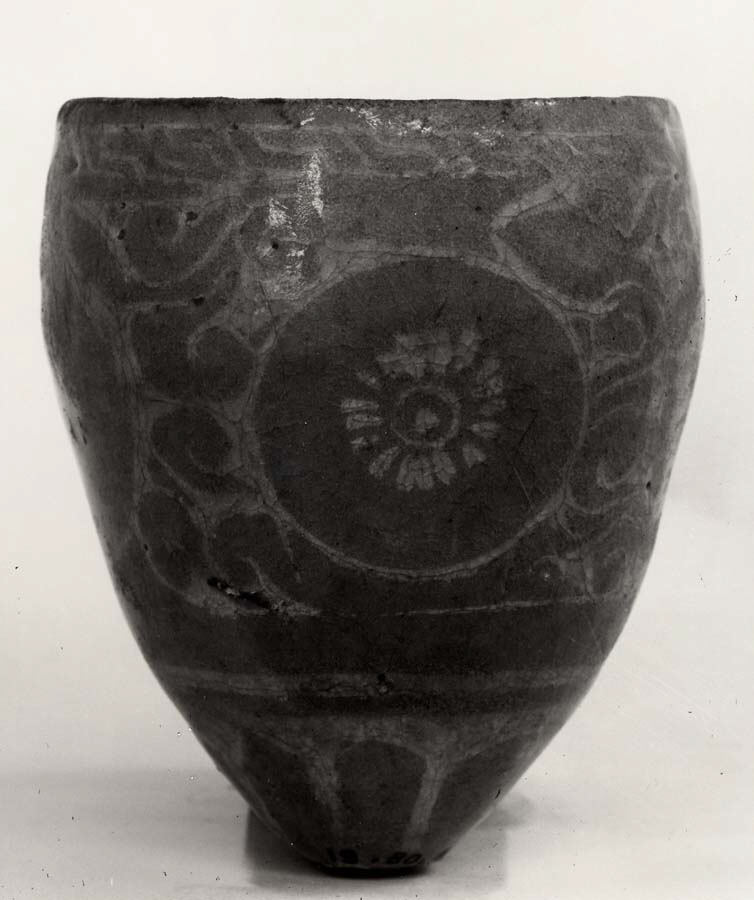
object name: cup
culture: korean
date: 1401-1600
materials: pottery